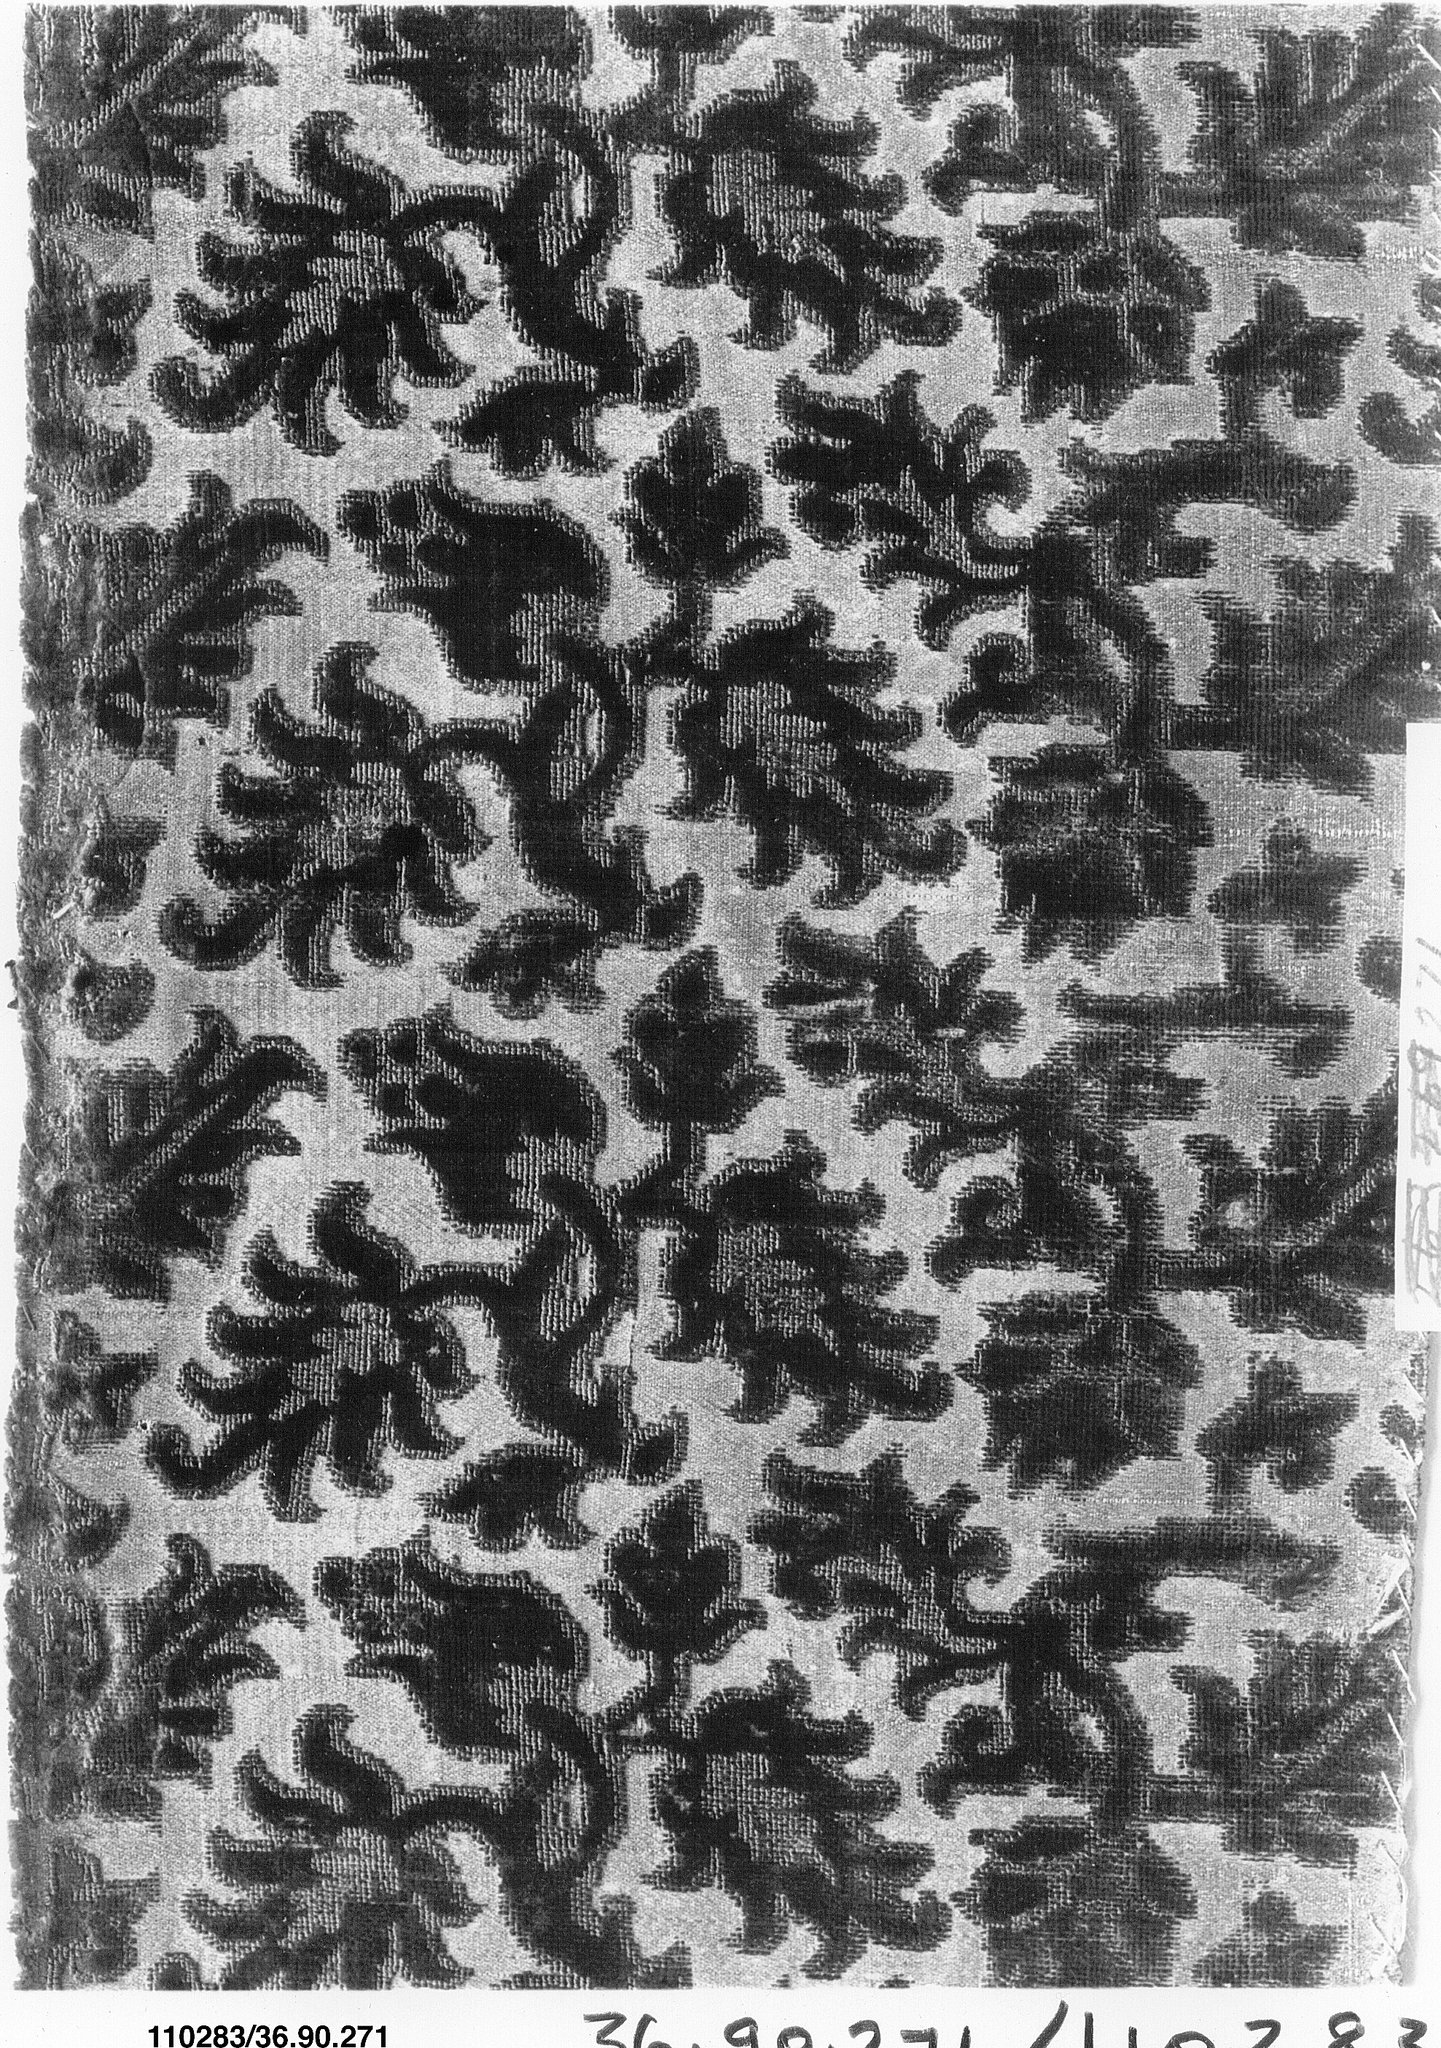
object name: piece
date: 1501-1700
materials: silk